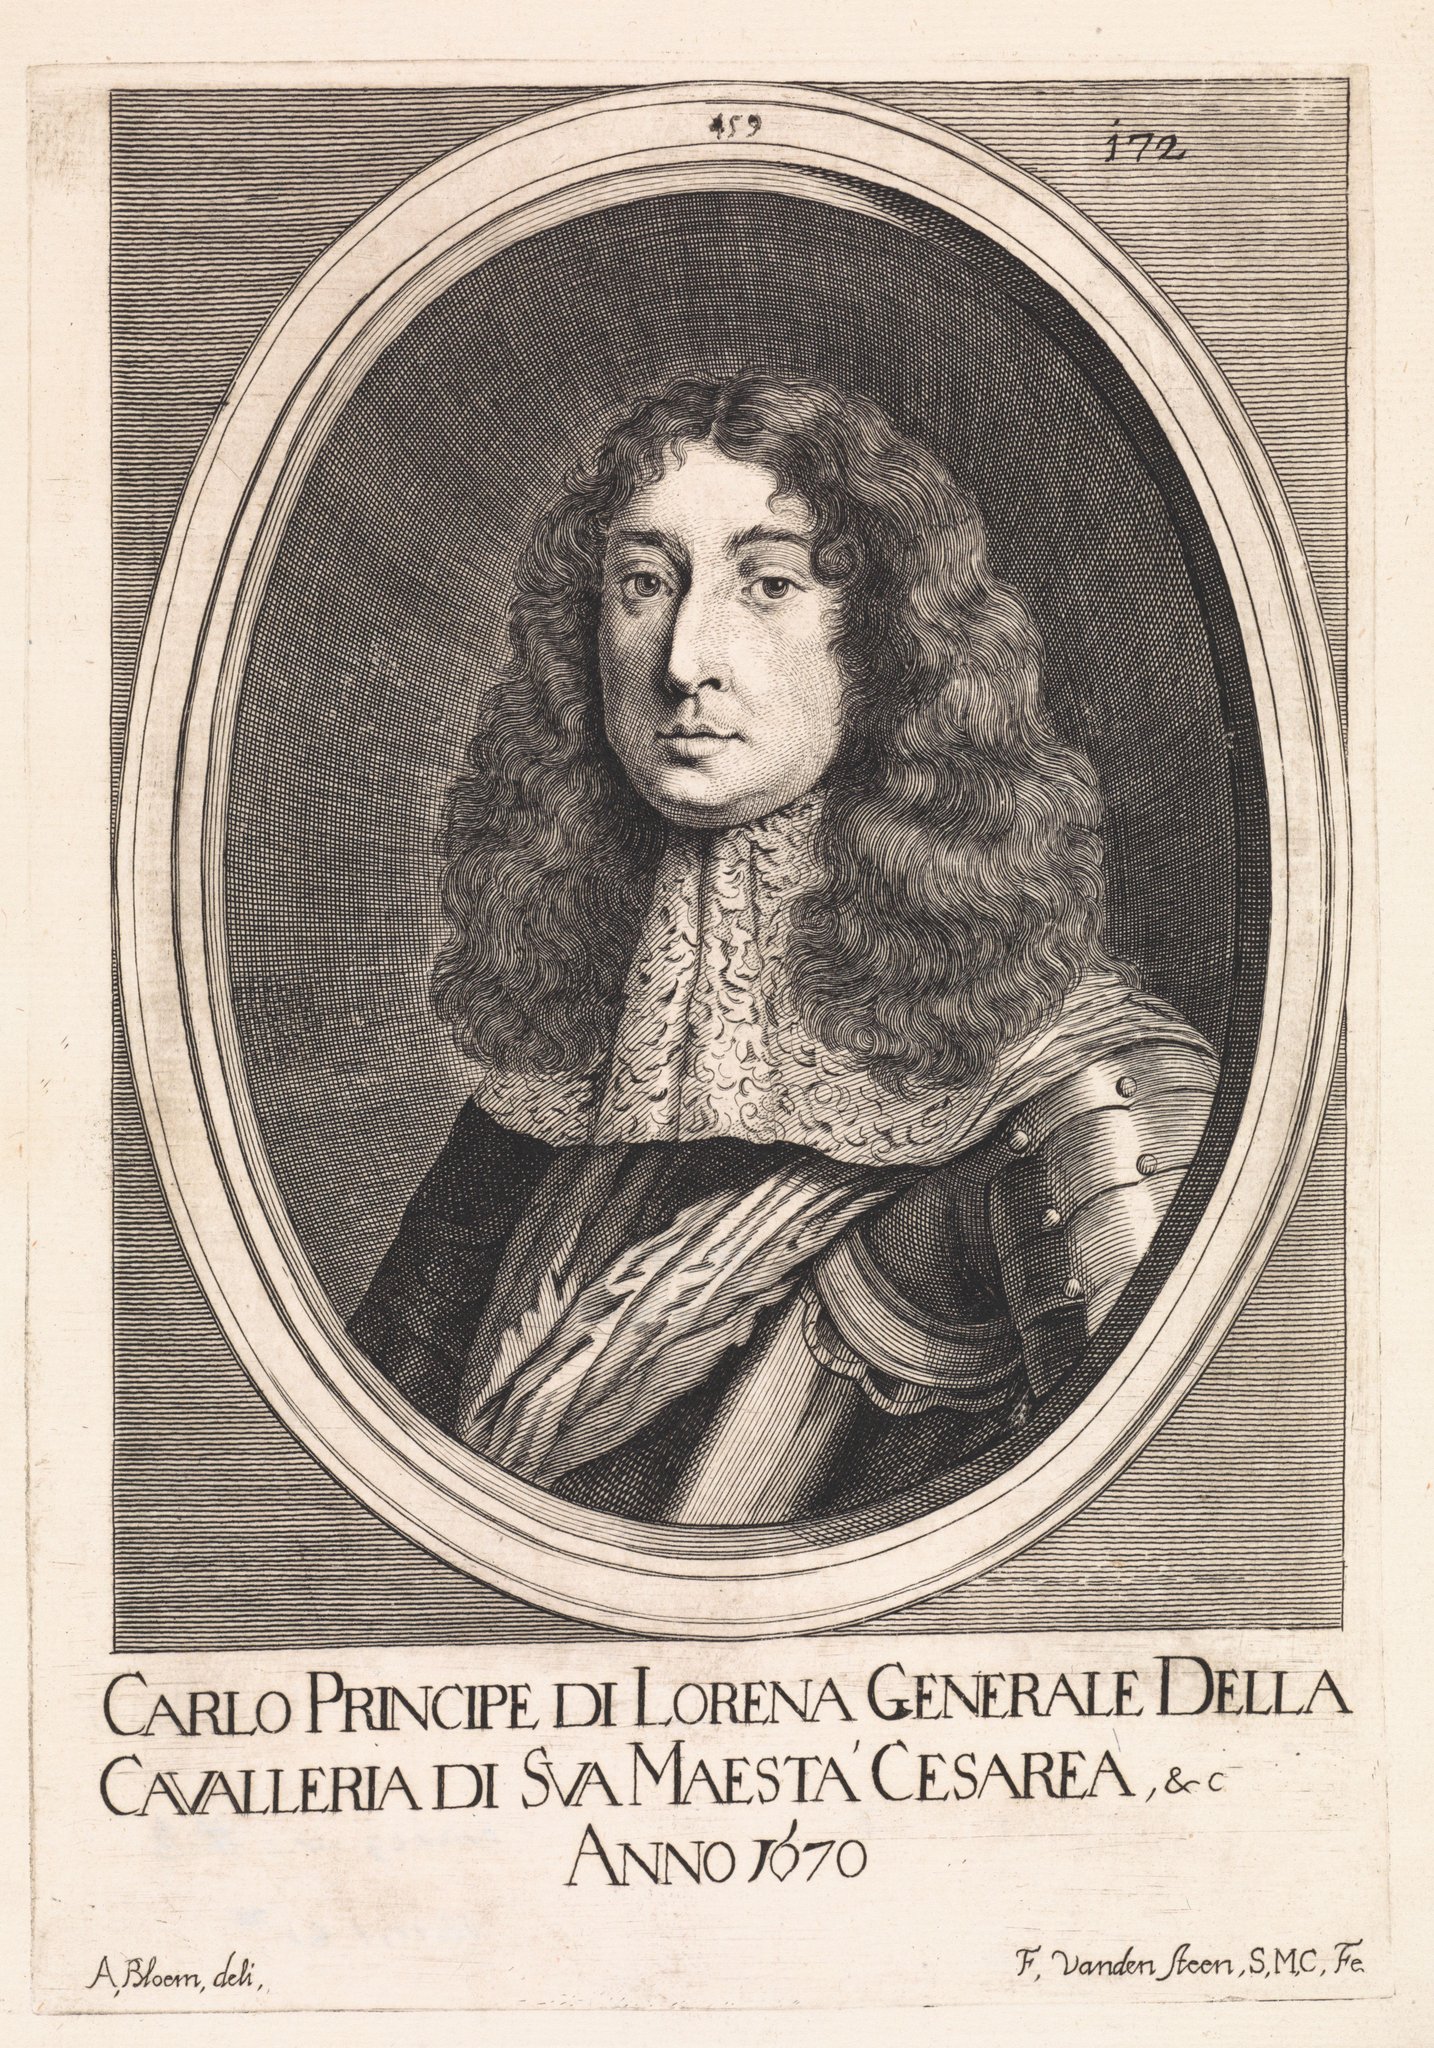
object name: book illustration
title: Portret van Karel V Leopold, hertog van Lotharingen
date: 1670-1674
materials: paper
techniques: engraving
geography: vienna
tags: wels, karel v leopold (hertog van lotharingen)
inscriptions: collector's mark: Lugt 2228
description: Portret van Karel V Leopold, hertog van Lotharingen, gekleed in harnas. Hij was generaal in het leger van de keizer Leopold I. Onderaan in de marge een drieregelige tekst in het Italiaans. Rechtsboven genummerd: i72. Boven de lijst genummerd: 459.